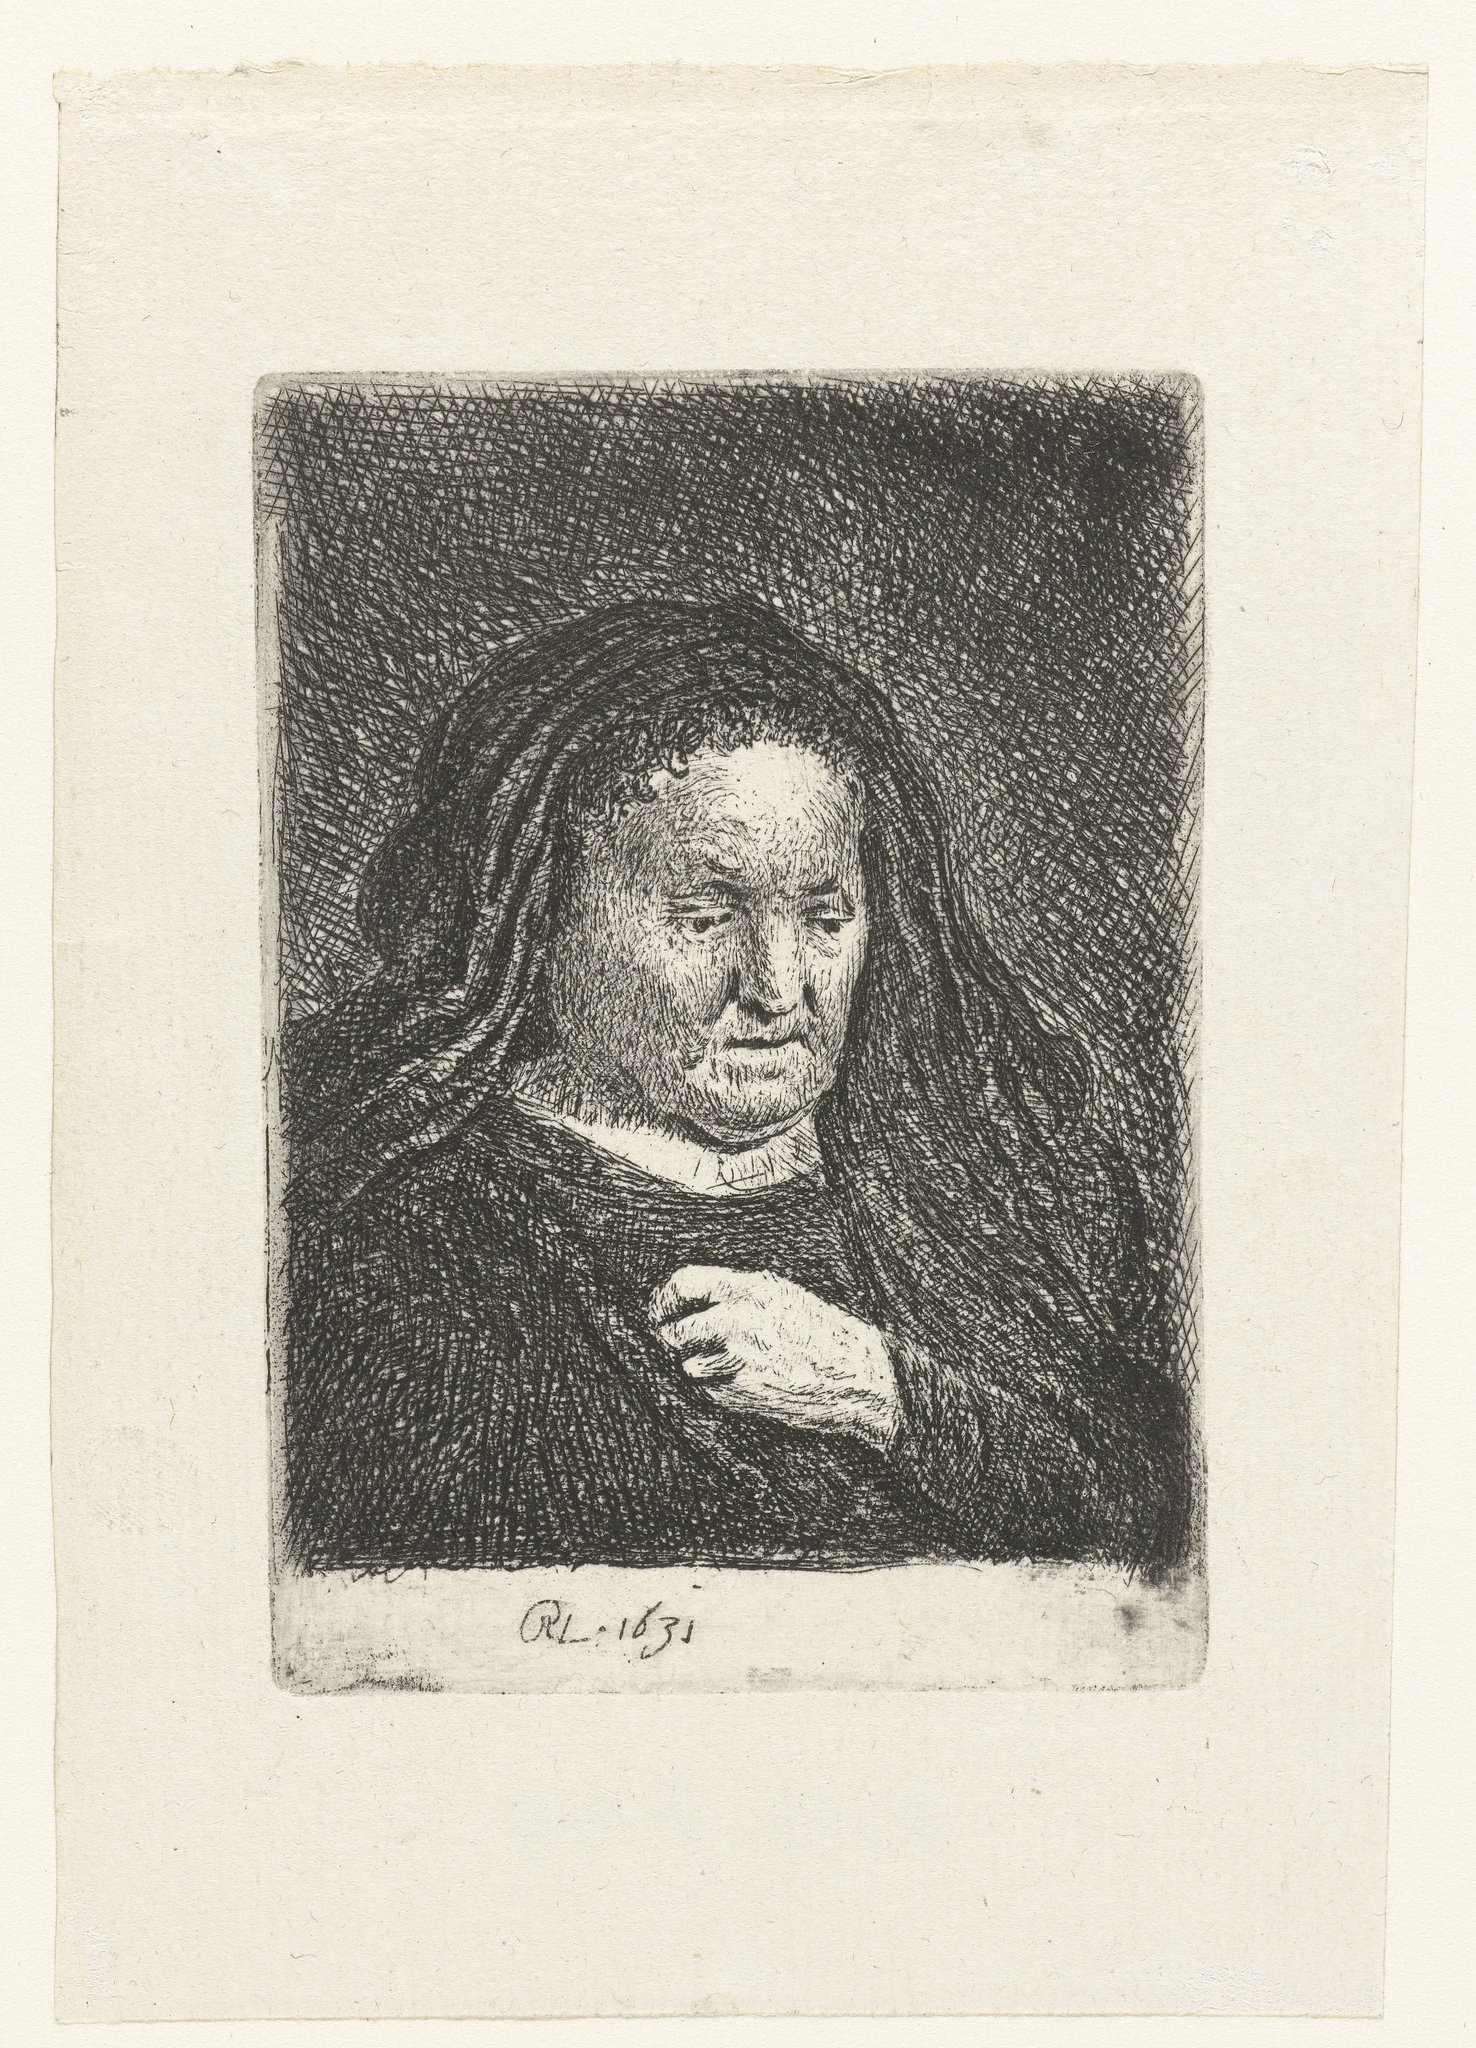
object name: print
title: The artist's mother with her hand on her chest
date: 1631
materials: paper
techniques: etching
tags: neeltje willemsdr. zuytbrouck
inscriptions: monogram and date: ‘RHL 1631’, inscription: ‘Coppier’